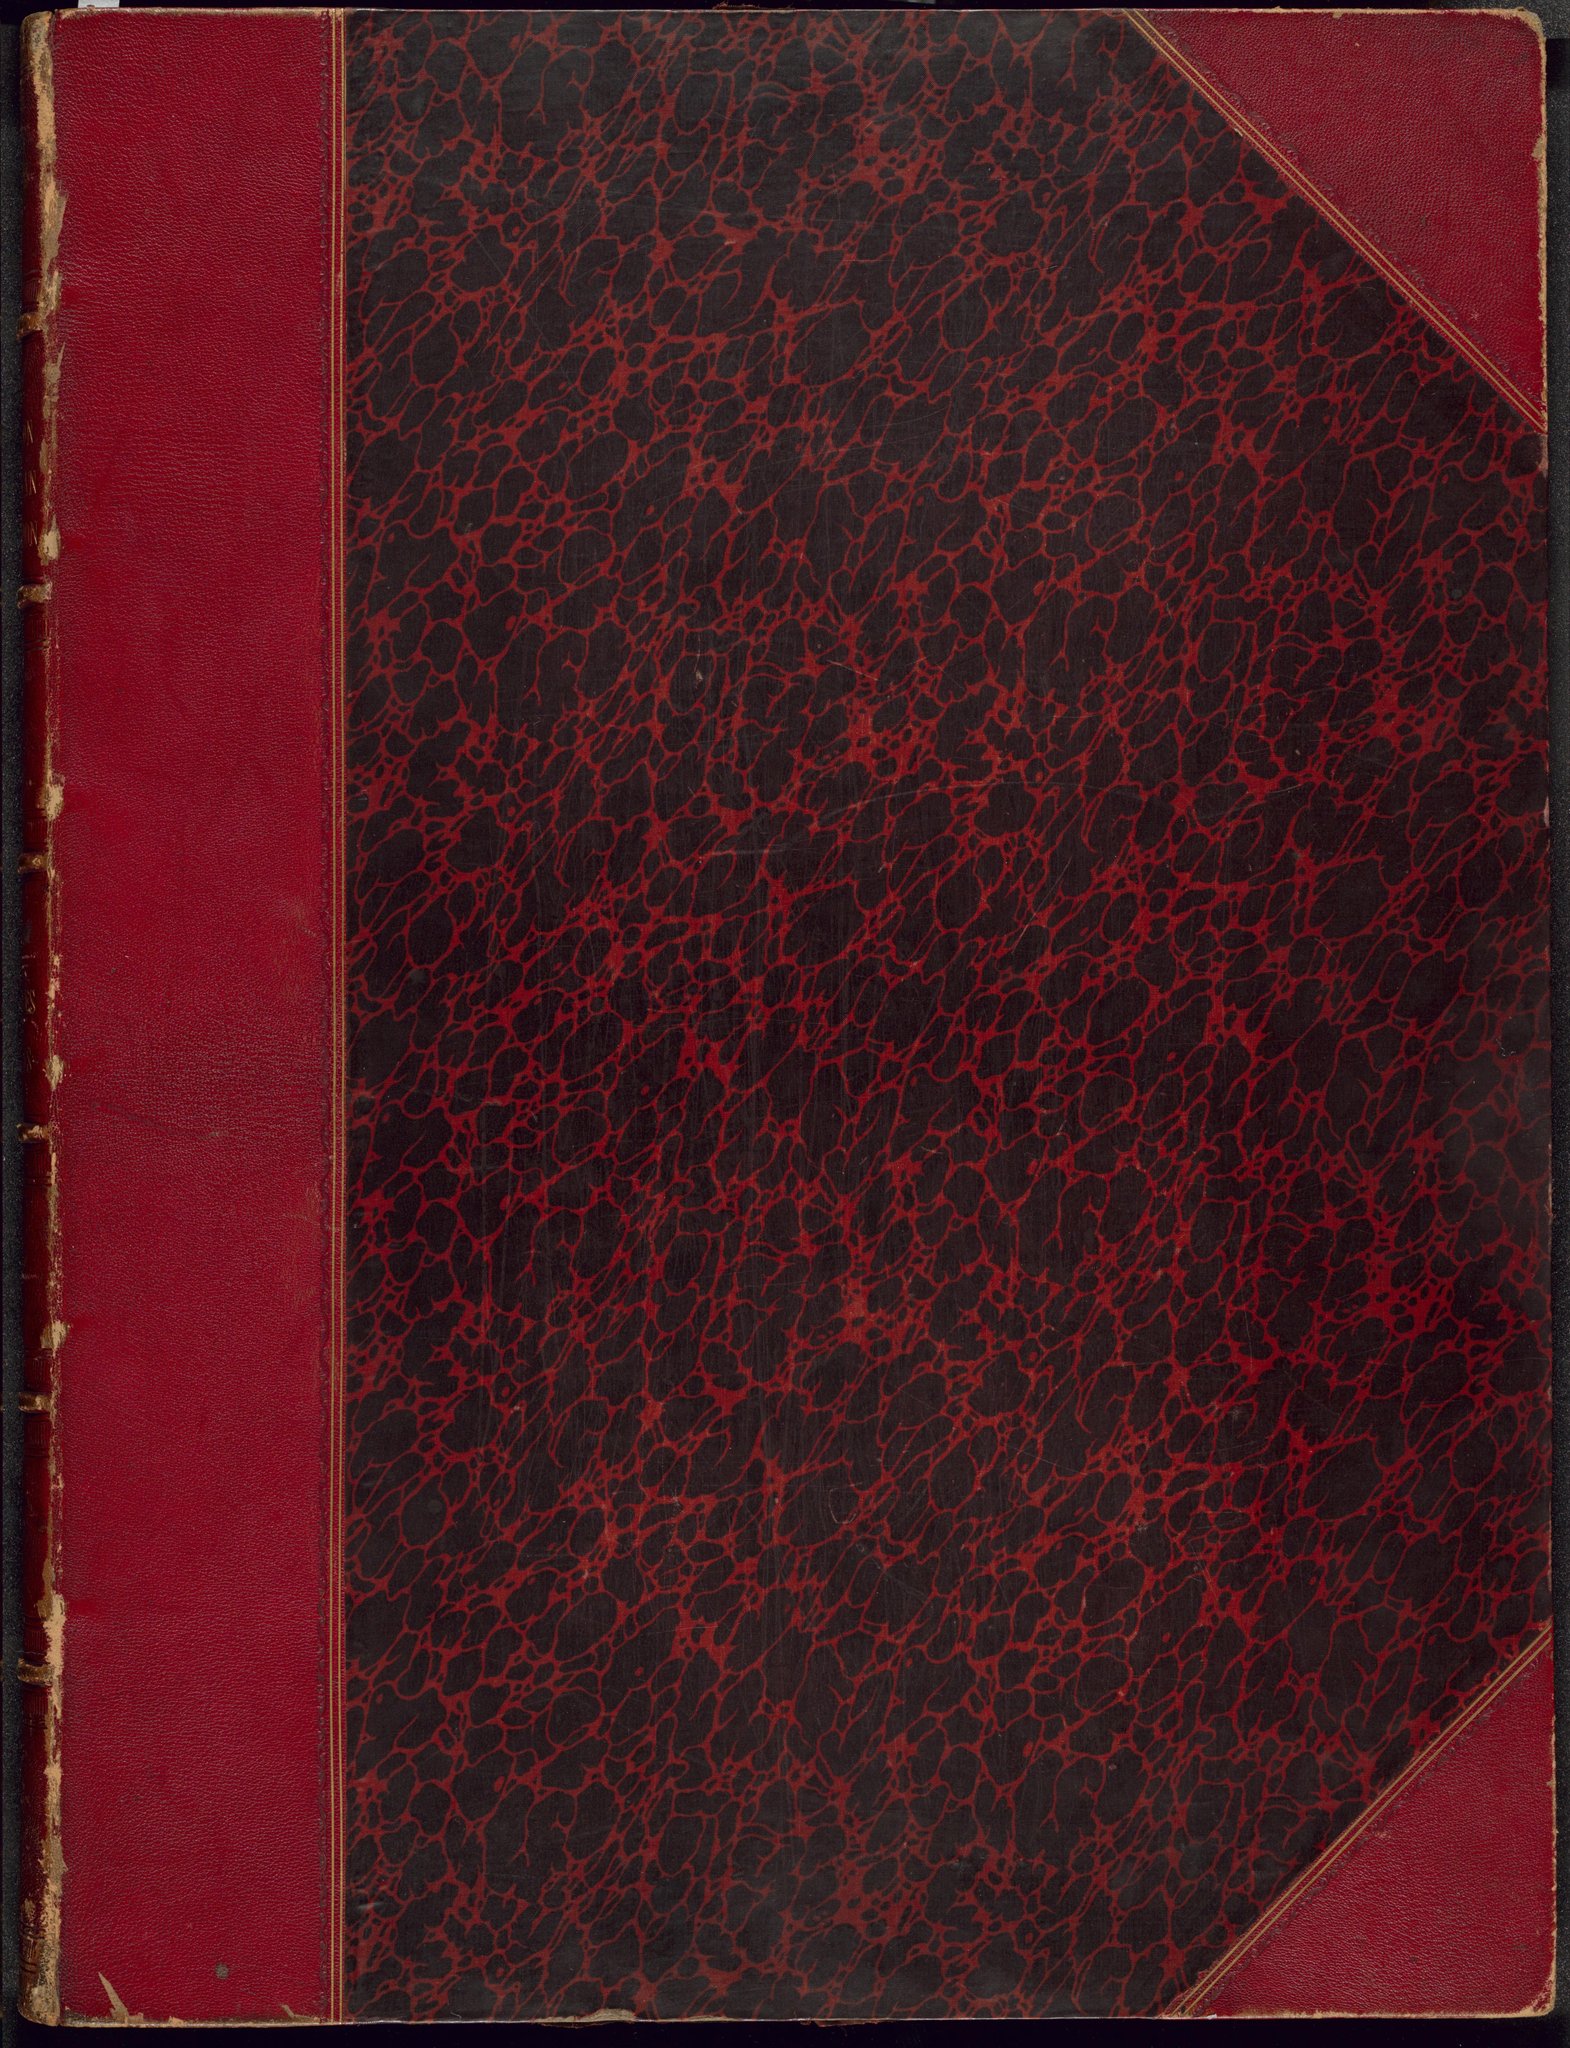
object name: album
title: The Gordon African Collection : Men, reptiles, fishes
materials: chalk, paint, ink, paper, pencil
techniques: brush, pen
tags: james cook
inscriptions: annotation: ‘op sommige bladen’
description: De atlas van Gordon Robert Jacob Gordon (1743-1795) bekleedde aan de Kaap diverse hoge militaire functies. Tijdens expedities in het binnenland hield hij een dagboek bij en legde hij in waterverftekeningen vast wat hij zag – uit liefhebberij, maar ook als onderdeel van de wetenschappelijke beschrijving van de Kaap. Zijn ‘atlas’ omvat bijna 400 aquarellen. Gordons aquarellen van de Khoi, bewoners van het kustgebied, en de Xhosa ver in het binnenland geven een gedetailleerd beeld van de kleding, wapens en gebruiken van de inheemse bevolking. Ze laten ook zien hoe de VOC plaatselijke leiders aan zich bond en liet optreden als vertegenwoordigers van het VOC-bestuur: opperhoofden ontvingen geschenken en tekenen van waardigheid, zoals een grenadiershoed, een ringkraag of een stok met een zilveren knop. De Khoi en Xhosa werden door Gordon en zijn tijdgenoten respectievelijk Hottentotten en Strandlopers en Kaffers genoemd – namen met een beledigende bijklank die nu niet meer worden gebruikt. Aquarellen verkleuren als ze te lang aan licht worden blootgesteld. Daarom wordt hier elke vier maanden een nieuwe tekening uit de Gordon-atlas getoond.